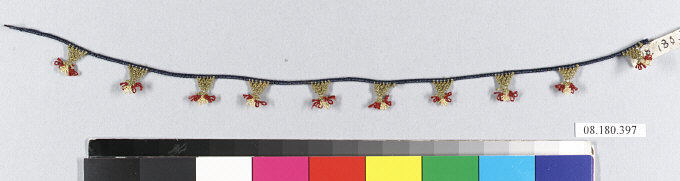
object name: fragment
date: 1801-1900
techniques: lace